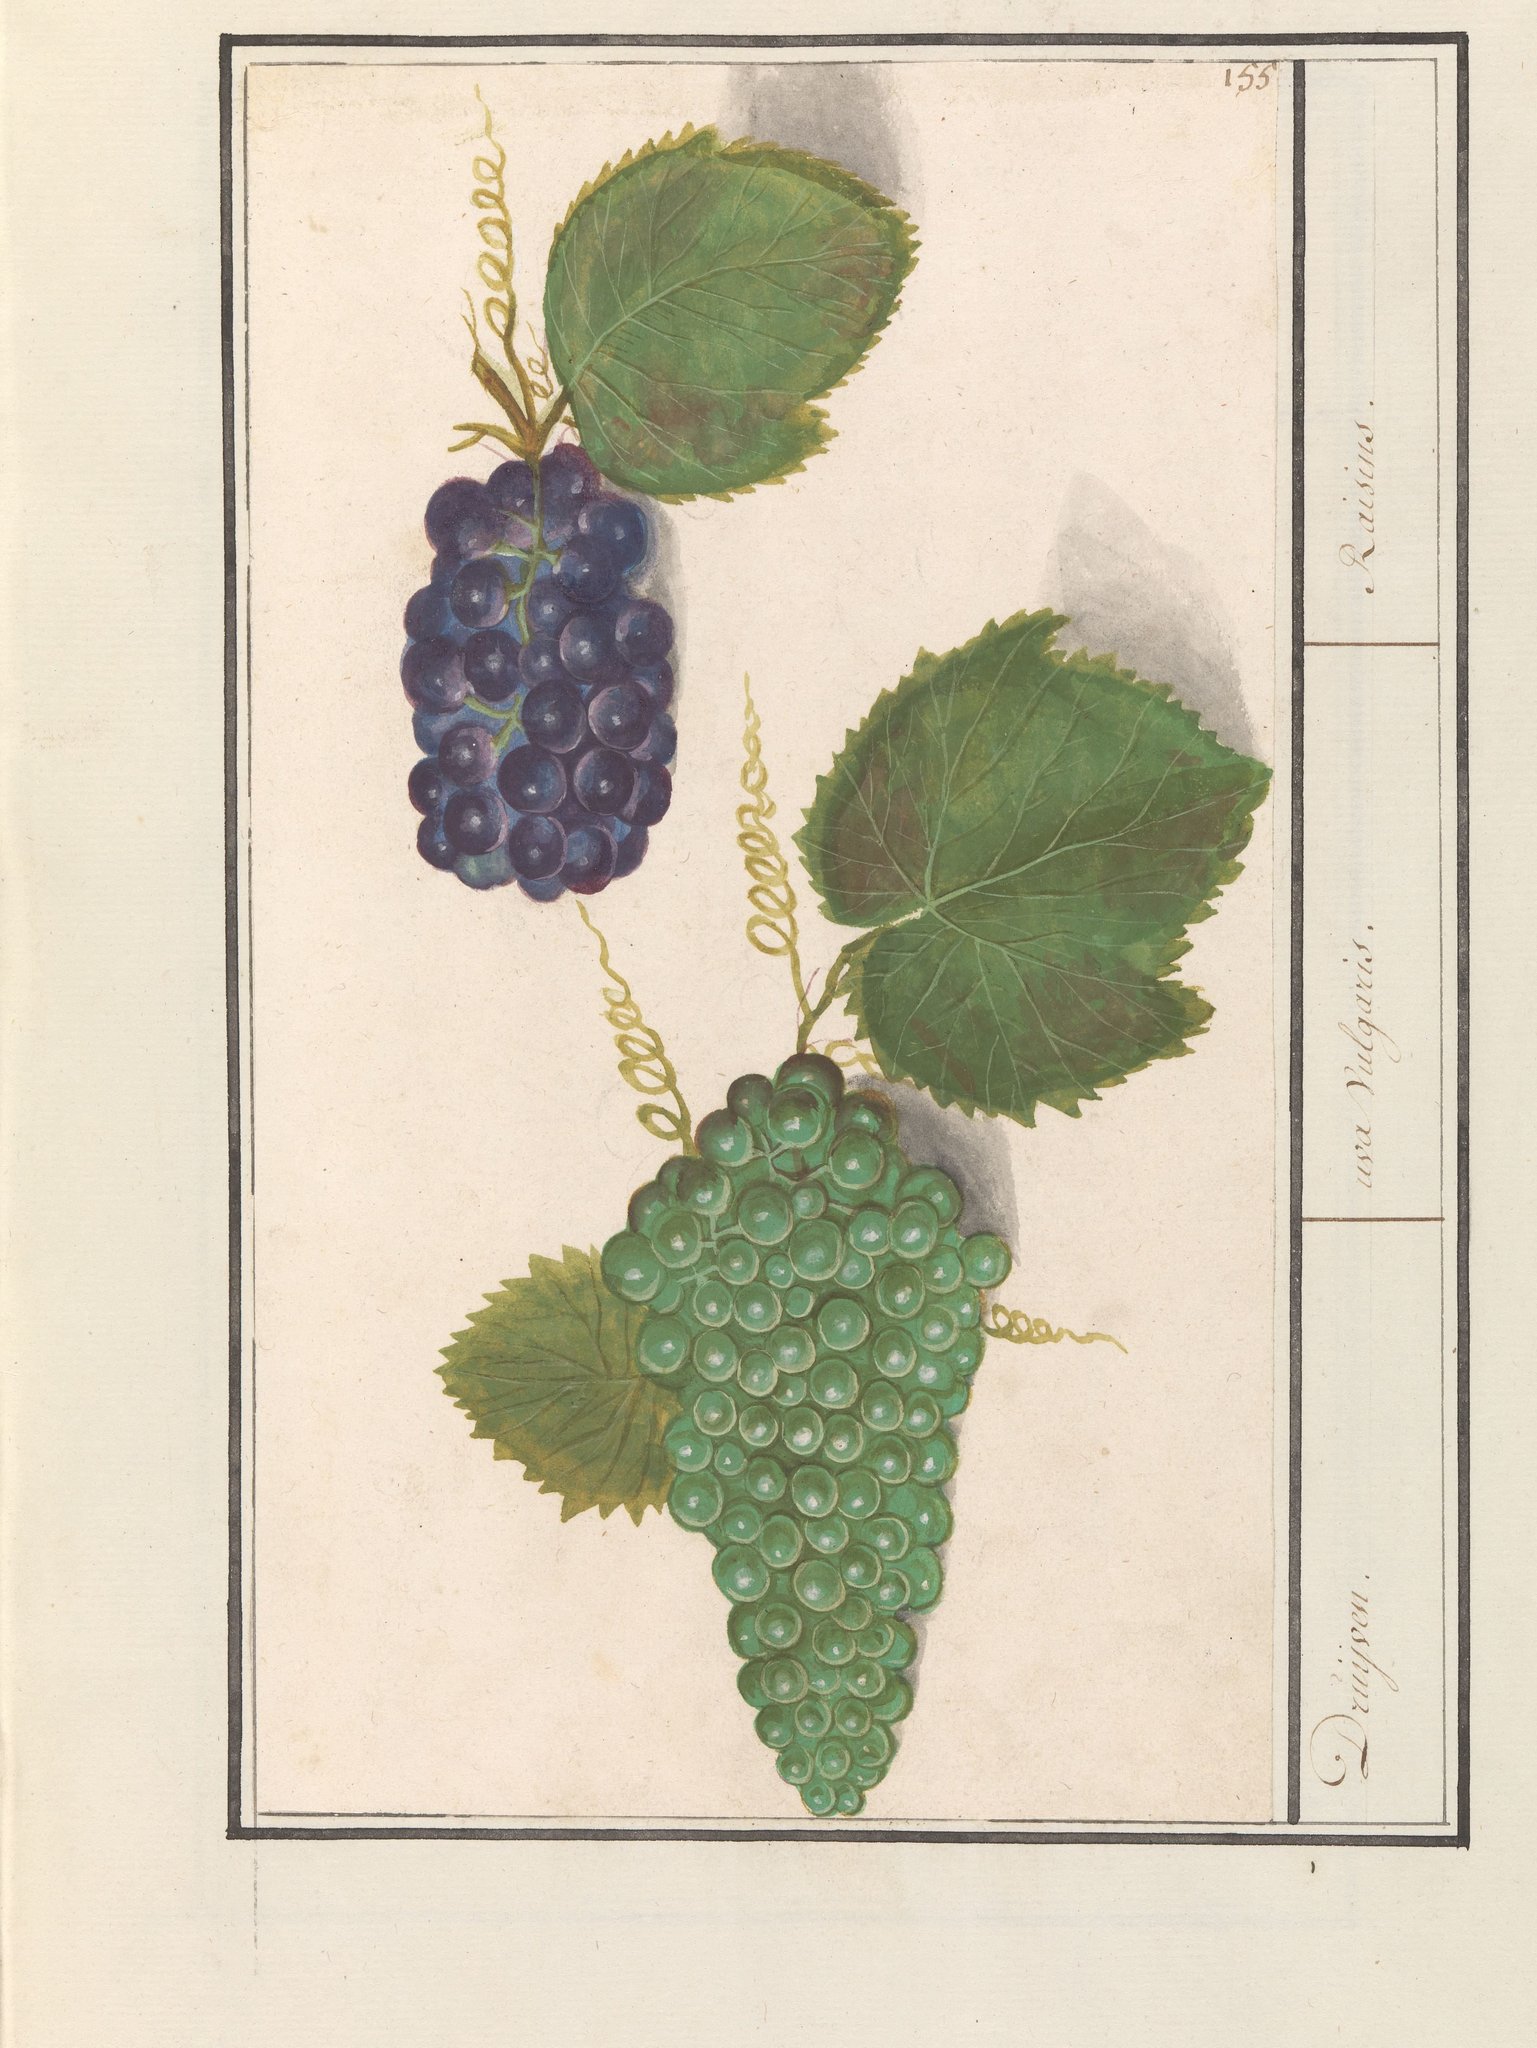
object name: drawing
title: Druijven. / uva Vulgaris. / Raisins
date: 1596-1610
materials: chalk, paint, ink, paper, watercolor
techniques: brush, pen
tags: fruits: grape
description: Groene en blauwe druiven. Rechtsboven genummerd: 155. Onderdeel van het tweede album met tekeningen van bloemen en planten. Negende van twaalf albums met tekeningen van dieren, vogels en planten bekend rond 1600, gemaakt in opdracht van keizer Rudolf II. Met toelichting in Nederlands, Latijn en Frans.